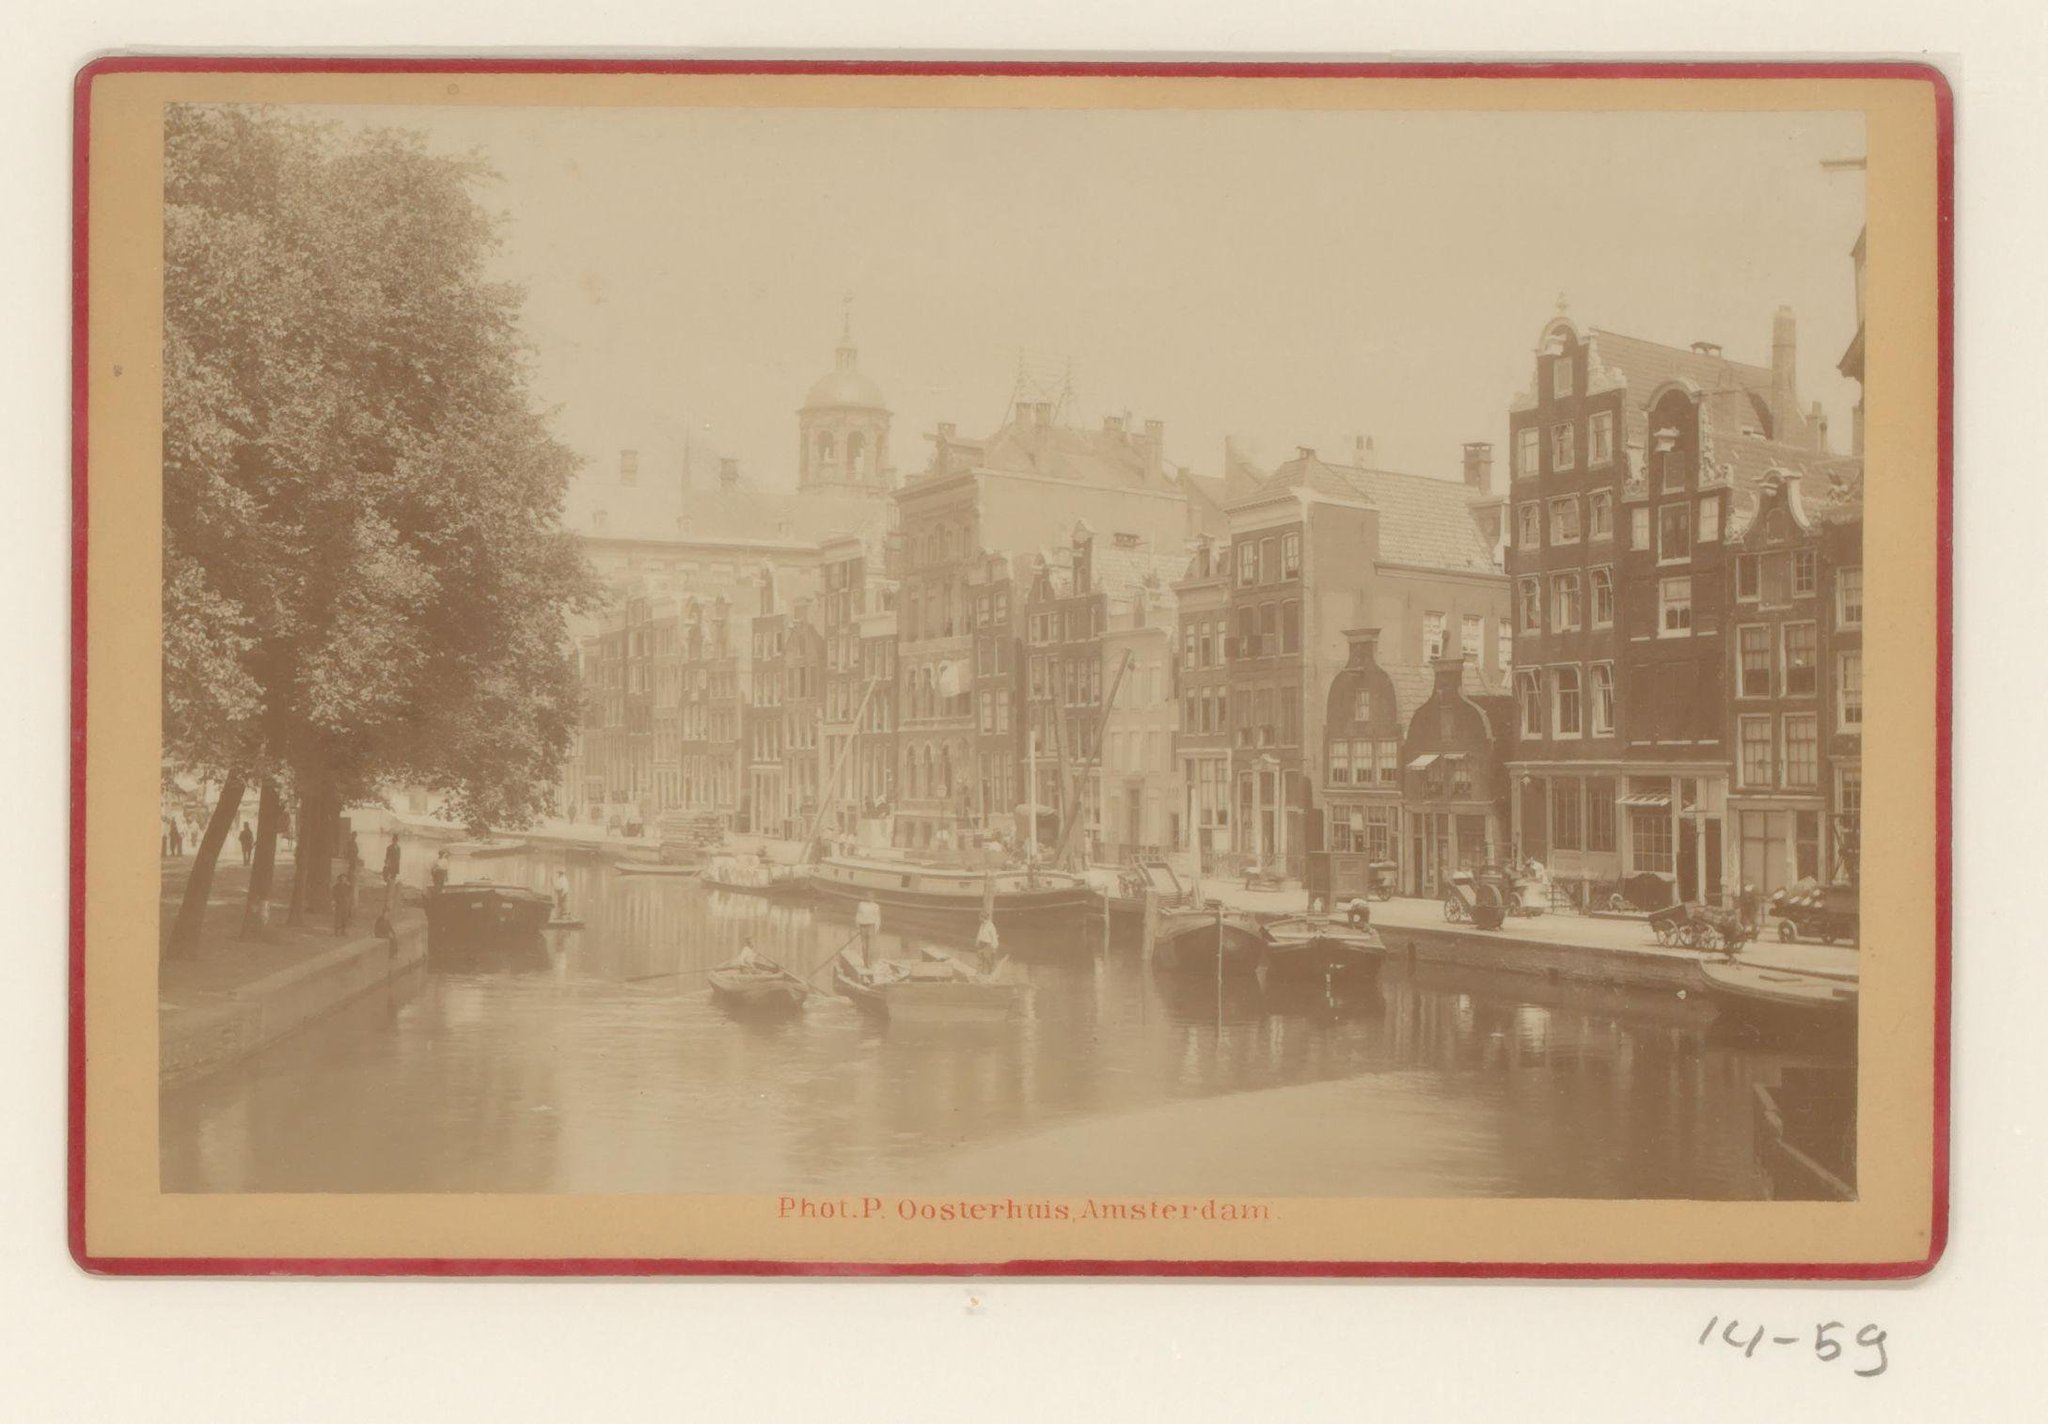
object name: cabinet photograph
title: Gezicht op de Nieuwezijds Voorburgwal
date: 1881-1884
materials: cardboard, paper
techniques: albumen print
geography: amsterdam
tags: city-view in general; 'veduta', canal, townhall, the usual house or row of houses, street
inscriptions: : ‘Boekhandel van / G.H.L. Winkelhagen / 7. Raamsteeg. 7. Amsterdam’, inscription: ‘Pijpenmarkt / voor de demping / neg. 13 x 18 : 303’, collector's mark: ‘14.59’ Lugt 1641b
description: Onderwerpsrubriek binnen de Atlas Amsterdam: Verhulststraat (Johannes), Viaducten, Vierwindenstraat, Vinkenbuurt, Vinkenpad, Vinkenstraat, Vischsteeg, Vliegendesteeg, Voetboogstraat, Volewijk, Vondelstraat, Voorburgwal (N.Z.).